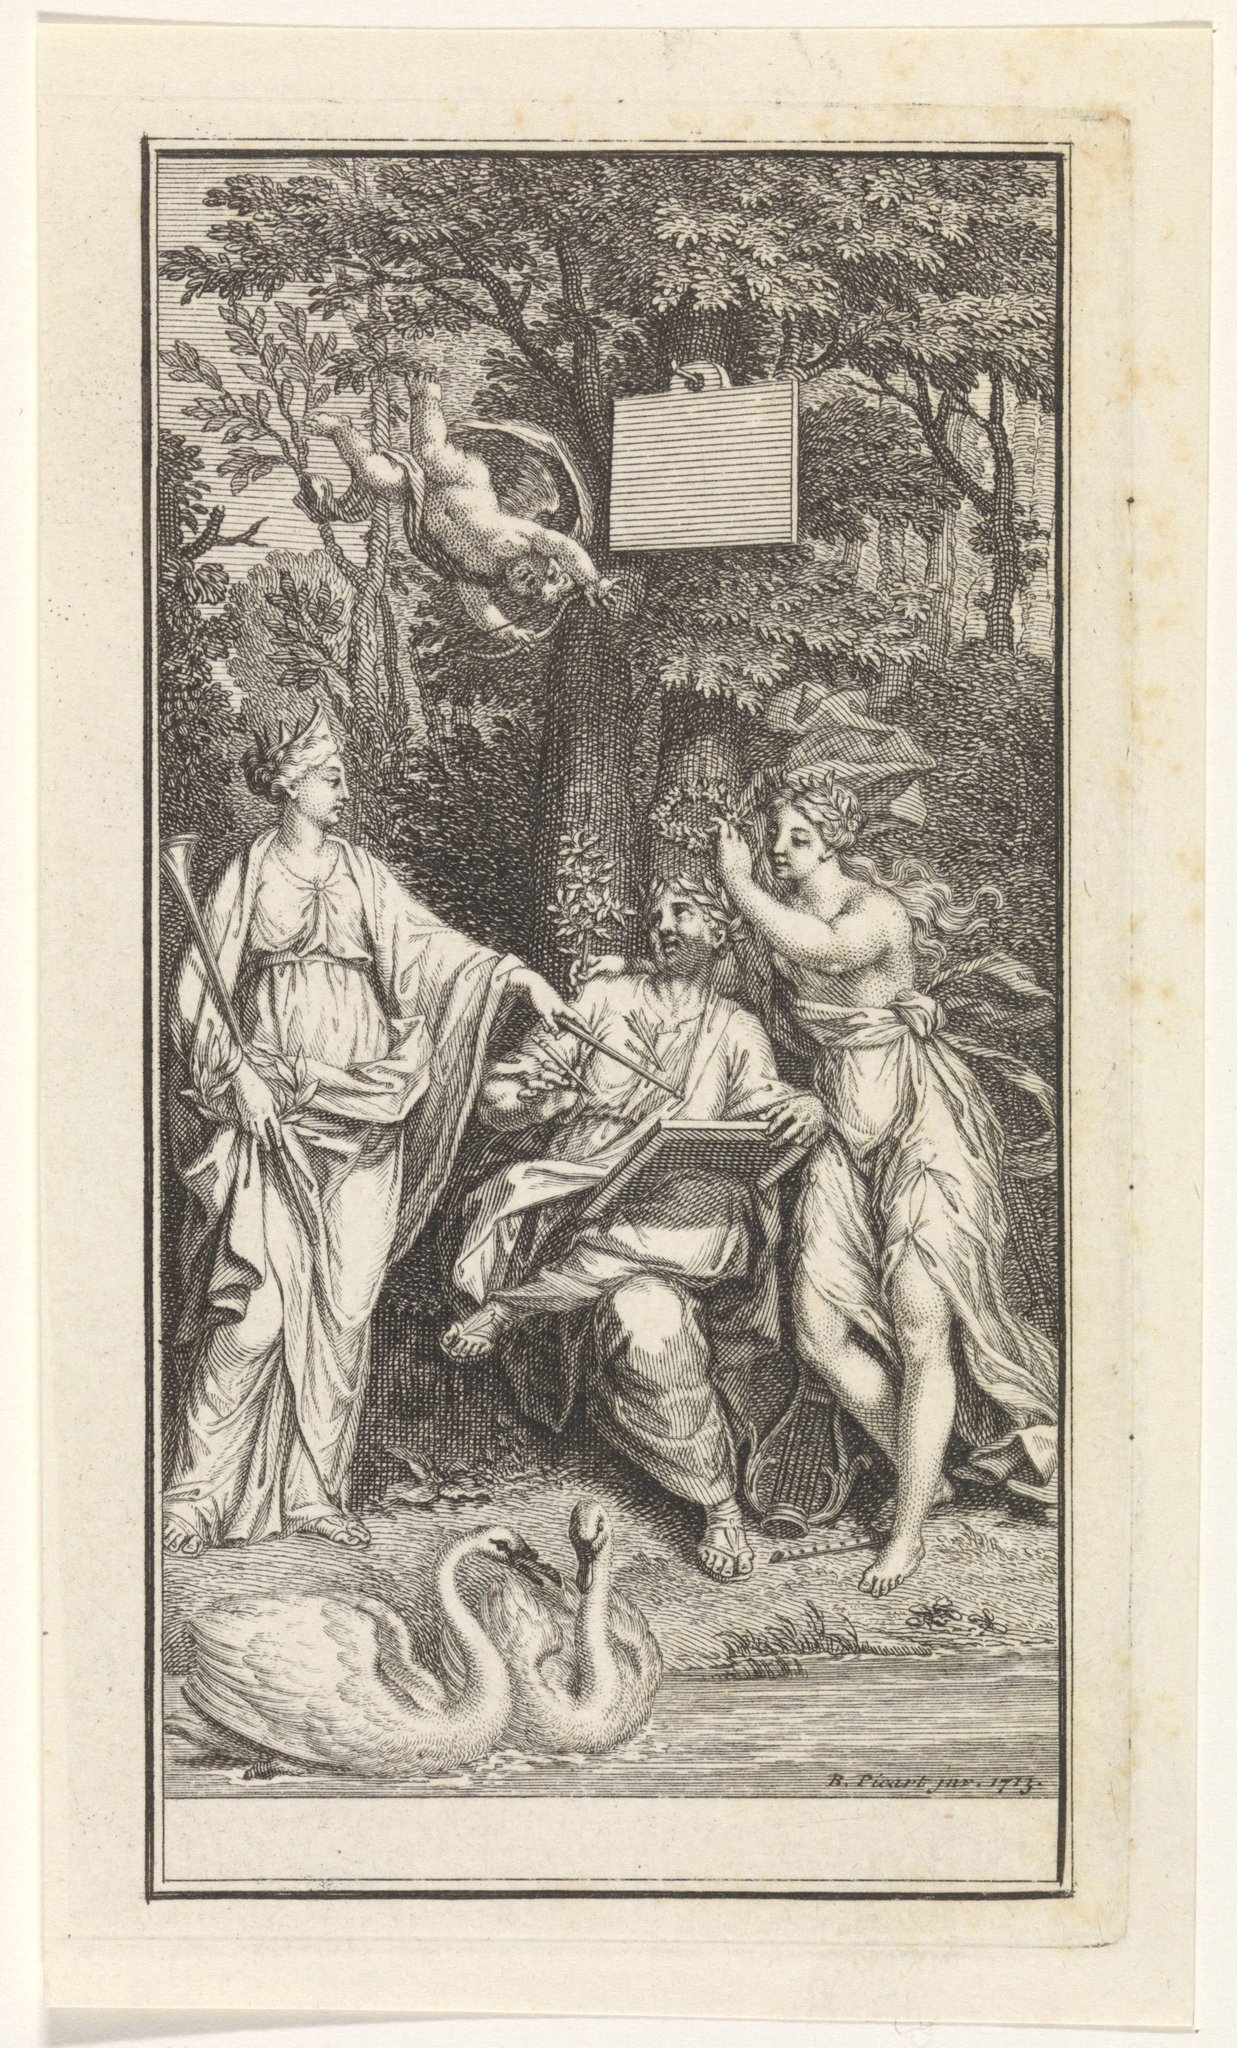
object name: print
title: Ovidius vergezeld door twee muzen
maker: bernard picart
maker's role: draughtsman, print maker, publisher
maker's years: 1673-1733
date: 1713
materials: paper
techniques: engraving, etching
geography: amsterdam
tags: publius ovidius naso, water-birds: swan, portrait of a writer, (story of) cupid, amor (eros), crowning with laurel, erato (one of the muses); 'erato' (ripa), melpomene (one of the muses); 'melpomene' (ripa)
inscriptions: collector's mark: Lugt 240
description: De dichter Publius Ovidius Naso is getroffen door een pijl van Amor die boven hem in de lucht vliegt. Hij is vergezeld door twee muzen Melpomene (hoorn in de hand) en Erato (lier aan de voeten). Op de voorgrond twee zwanen op het water. Op de achtergrond op een boom een leeg bord.